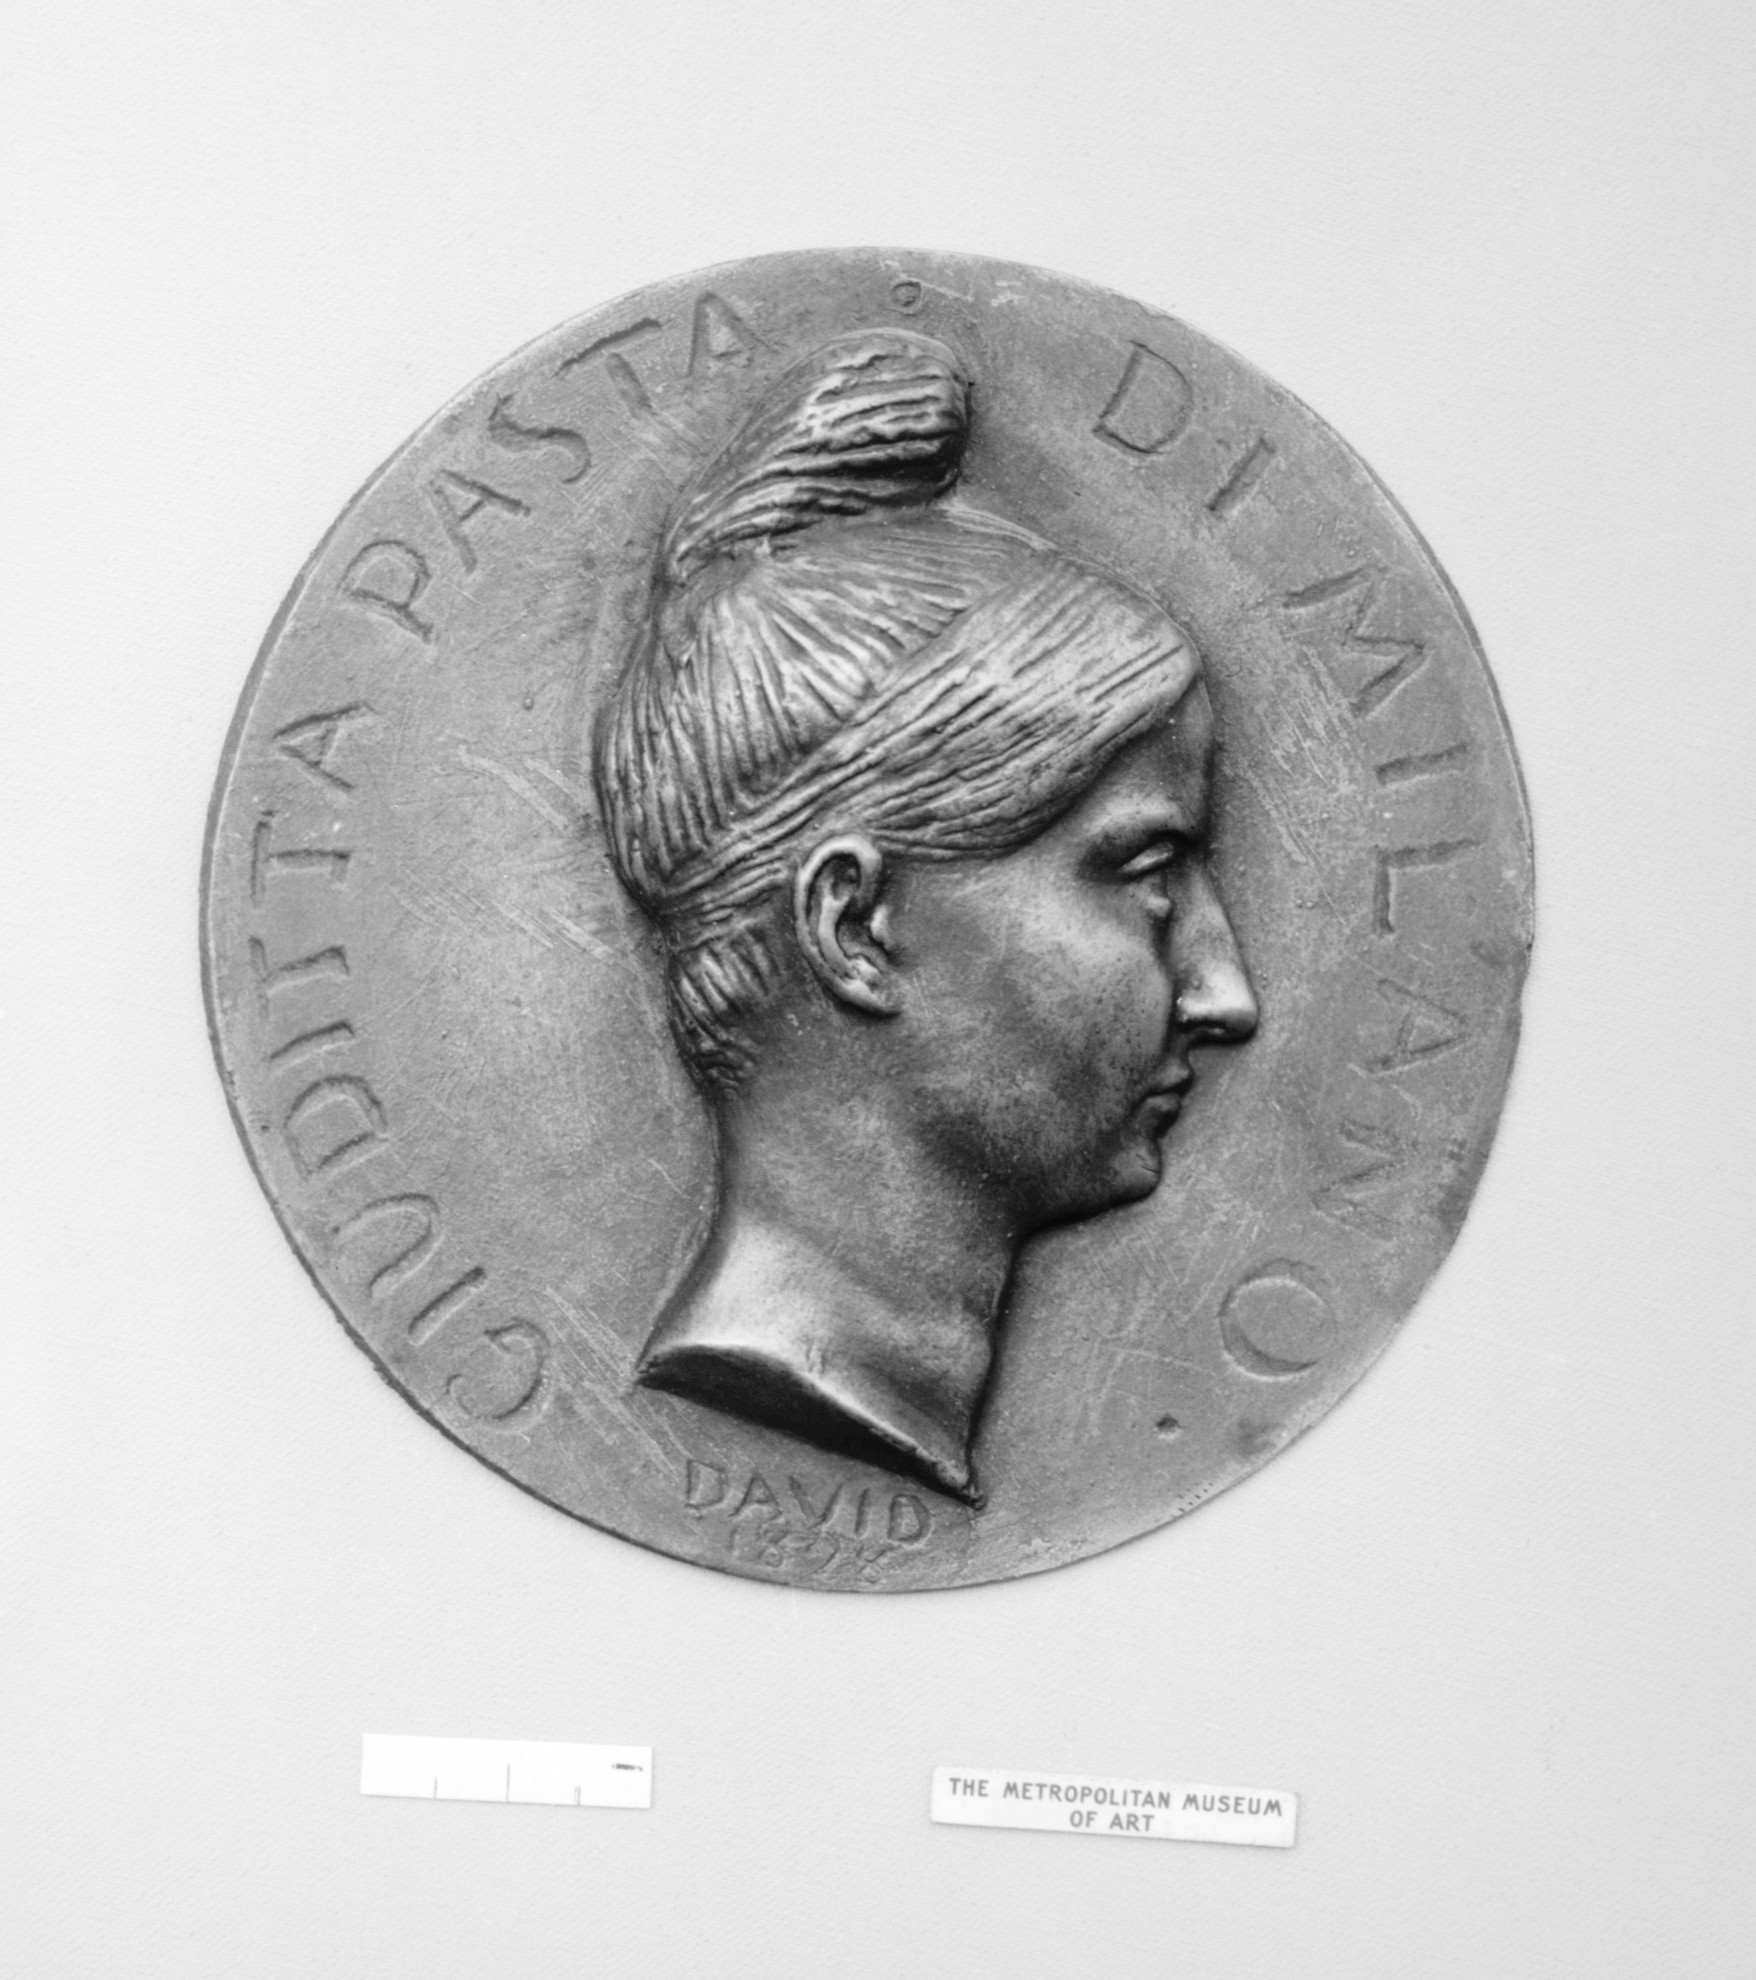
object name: medallion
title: Judith Pasta (1798–1865), Italian singer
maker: pierre jean david d'angers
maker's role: artist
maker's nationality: french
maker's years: 1788-1856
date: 1828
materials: bronze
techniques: casting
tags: profiles,women